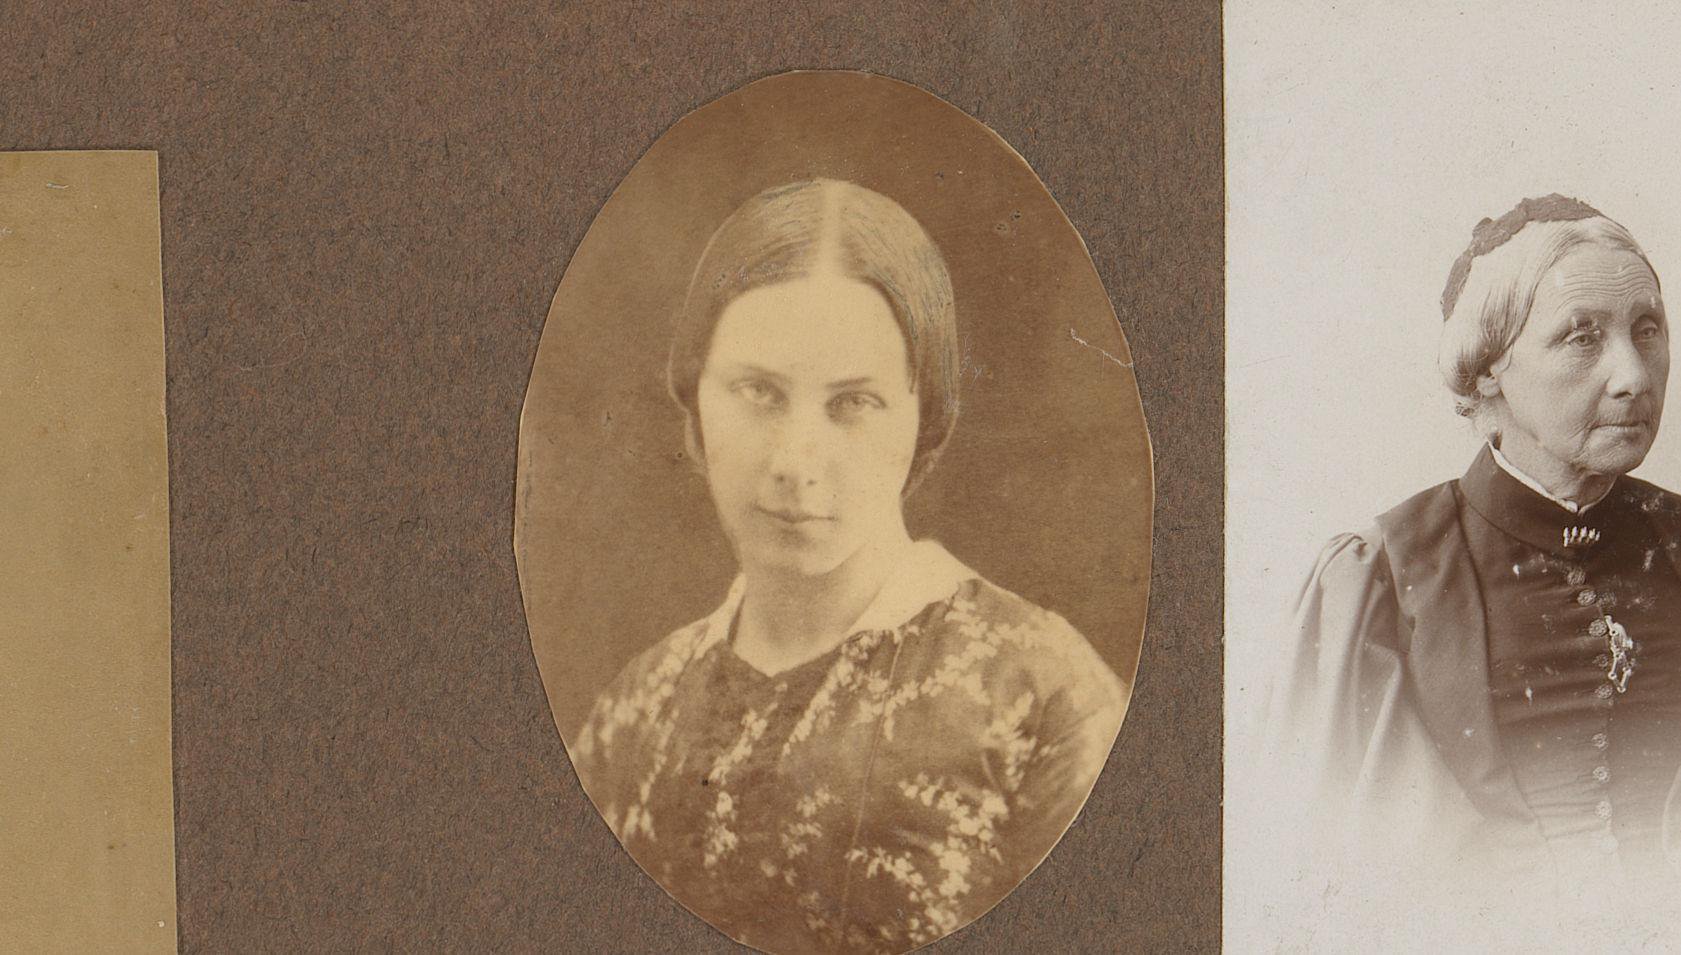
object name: photograph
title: Ovaal portret van vrouw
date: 1880-1910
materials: photographic support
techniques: photography, snipping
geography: netherlands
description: Foto op bruin albumblad 29 van familiealbum van Alphons Diepenbrock.